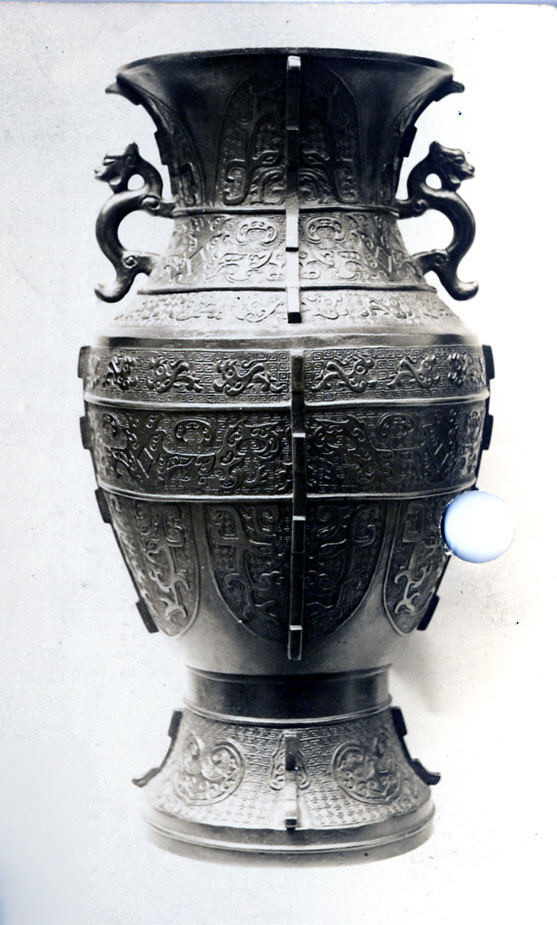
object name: vase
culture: chinese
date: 1701-1900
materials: bronze